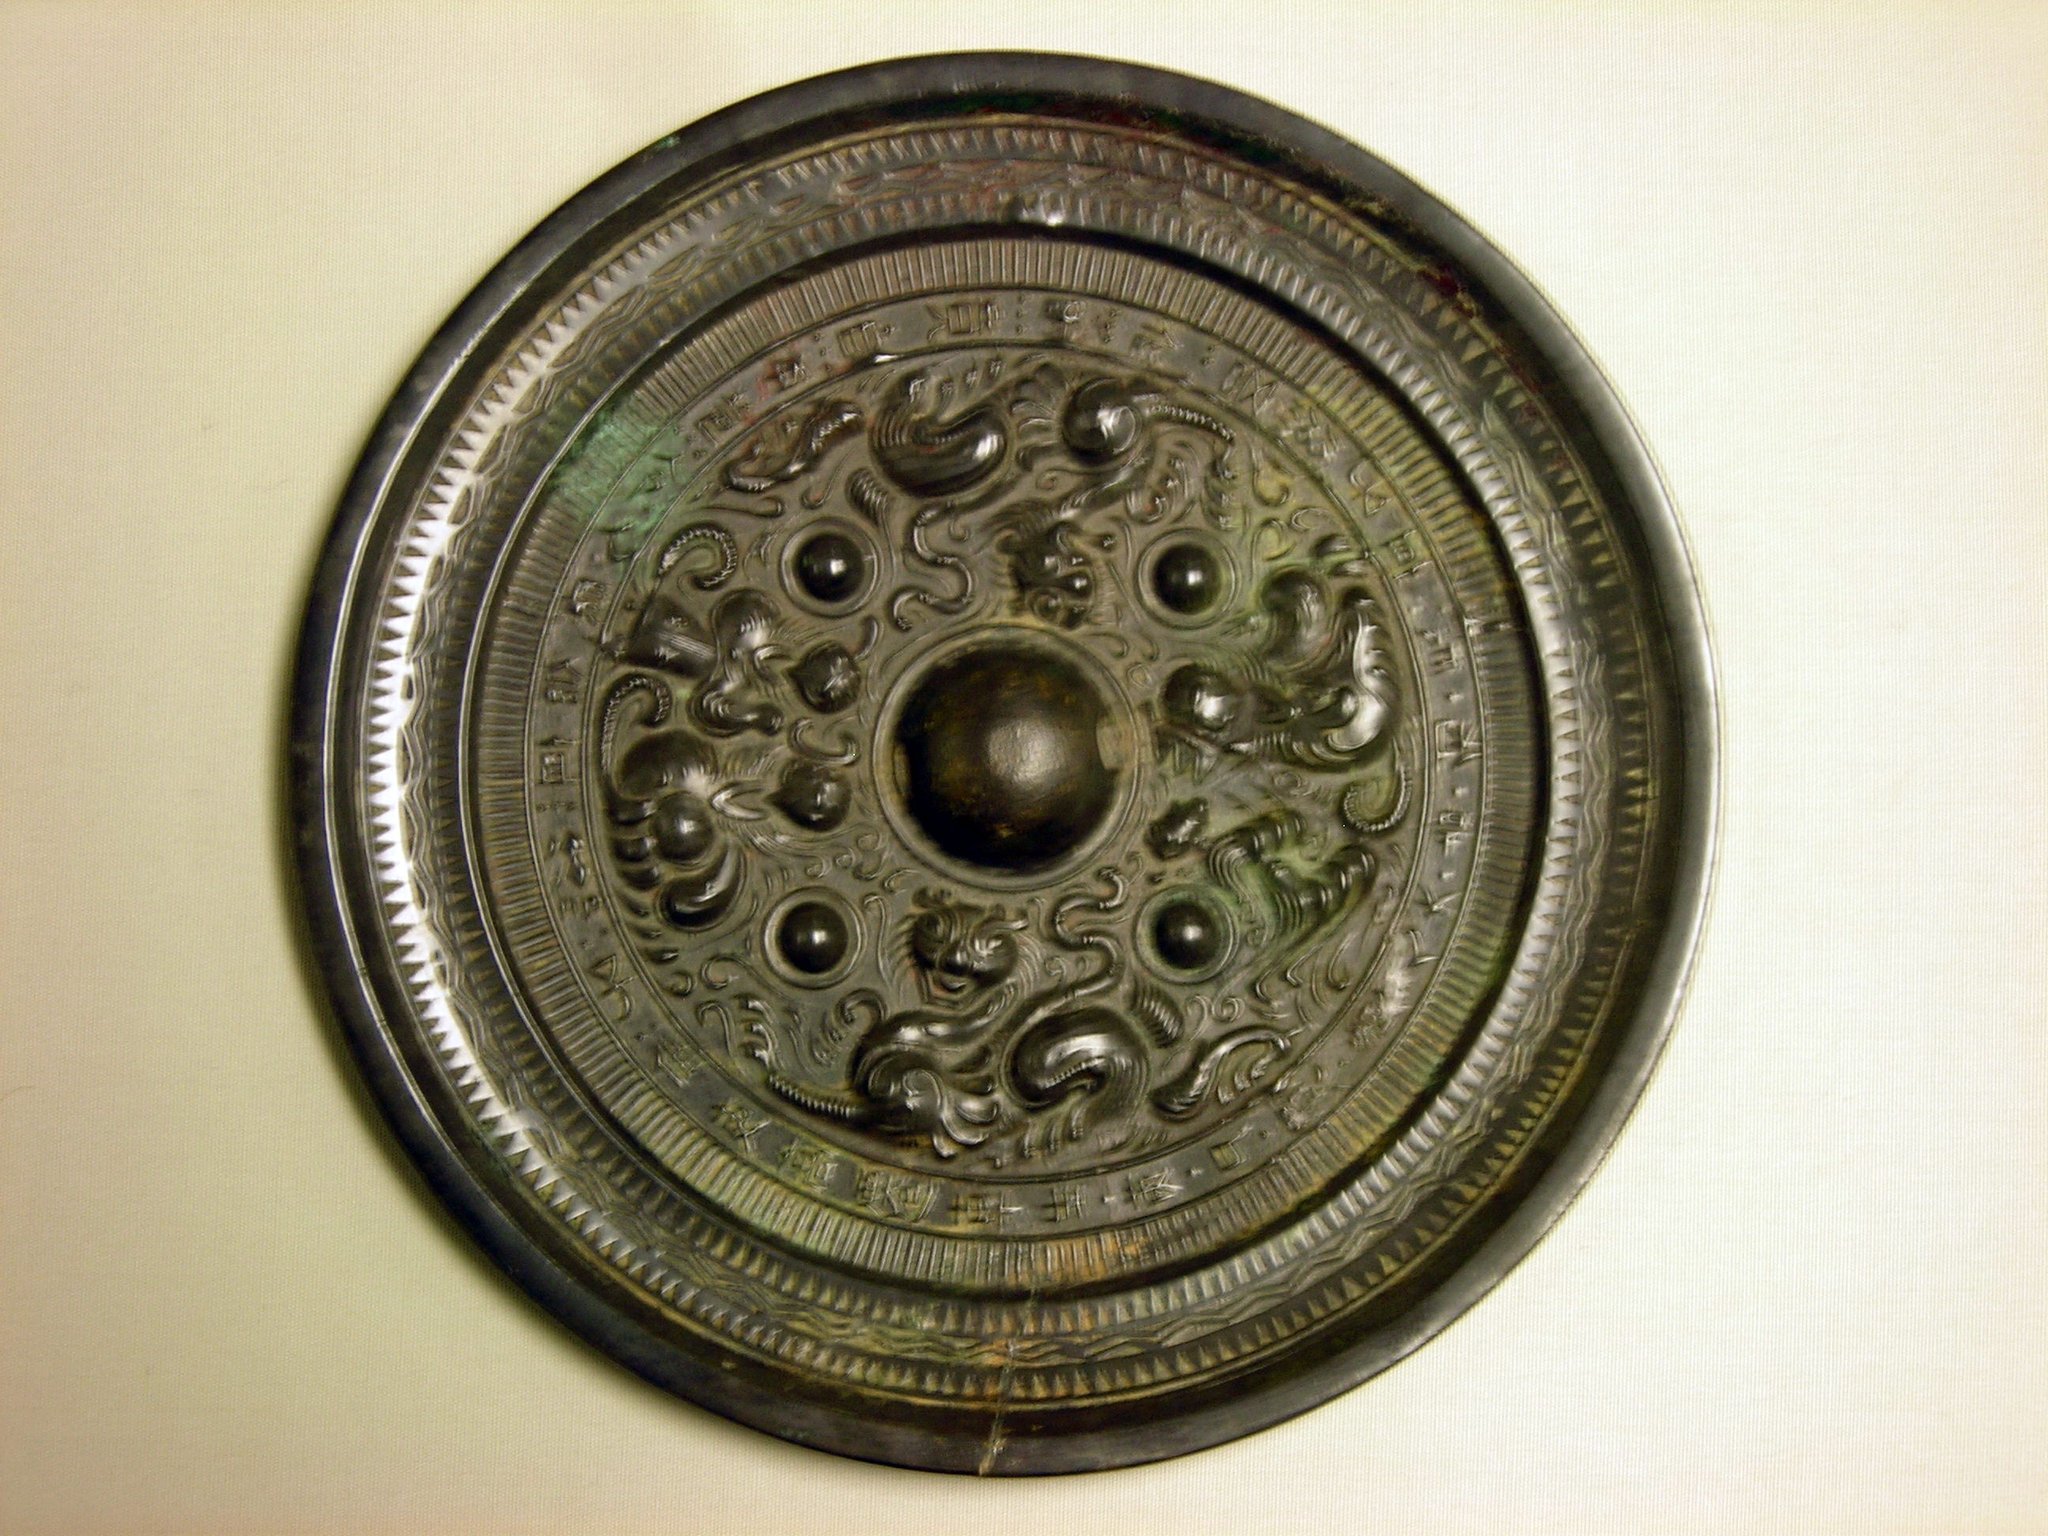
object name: mirror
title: Mirror with deities and mythical creatures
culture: chinese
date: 1-200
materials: bronze